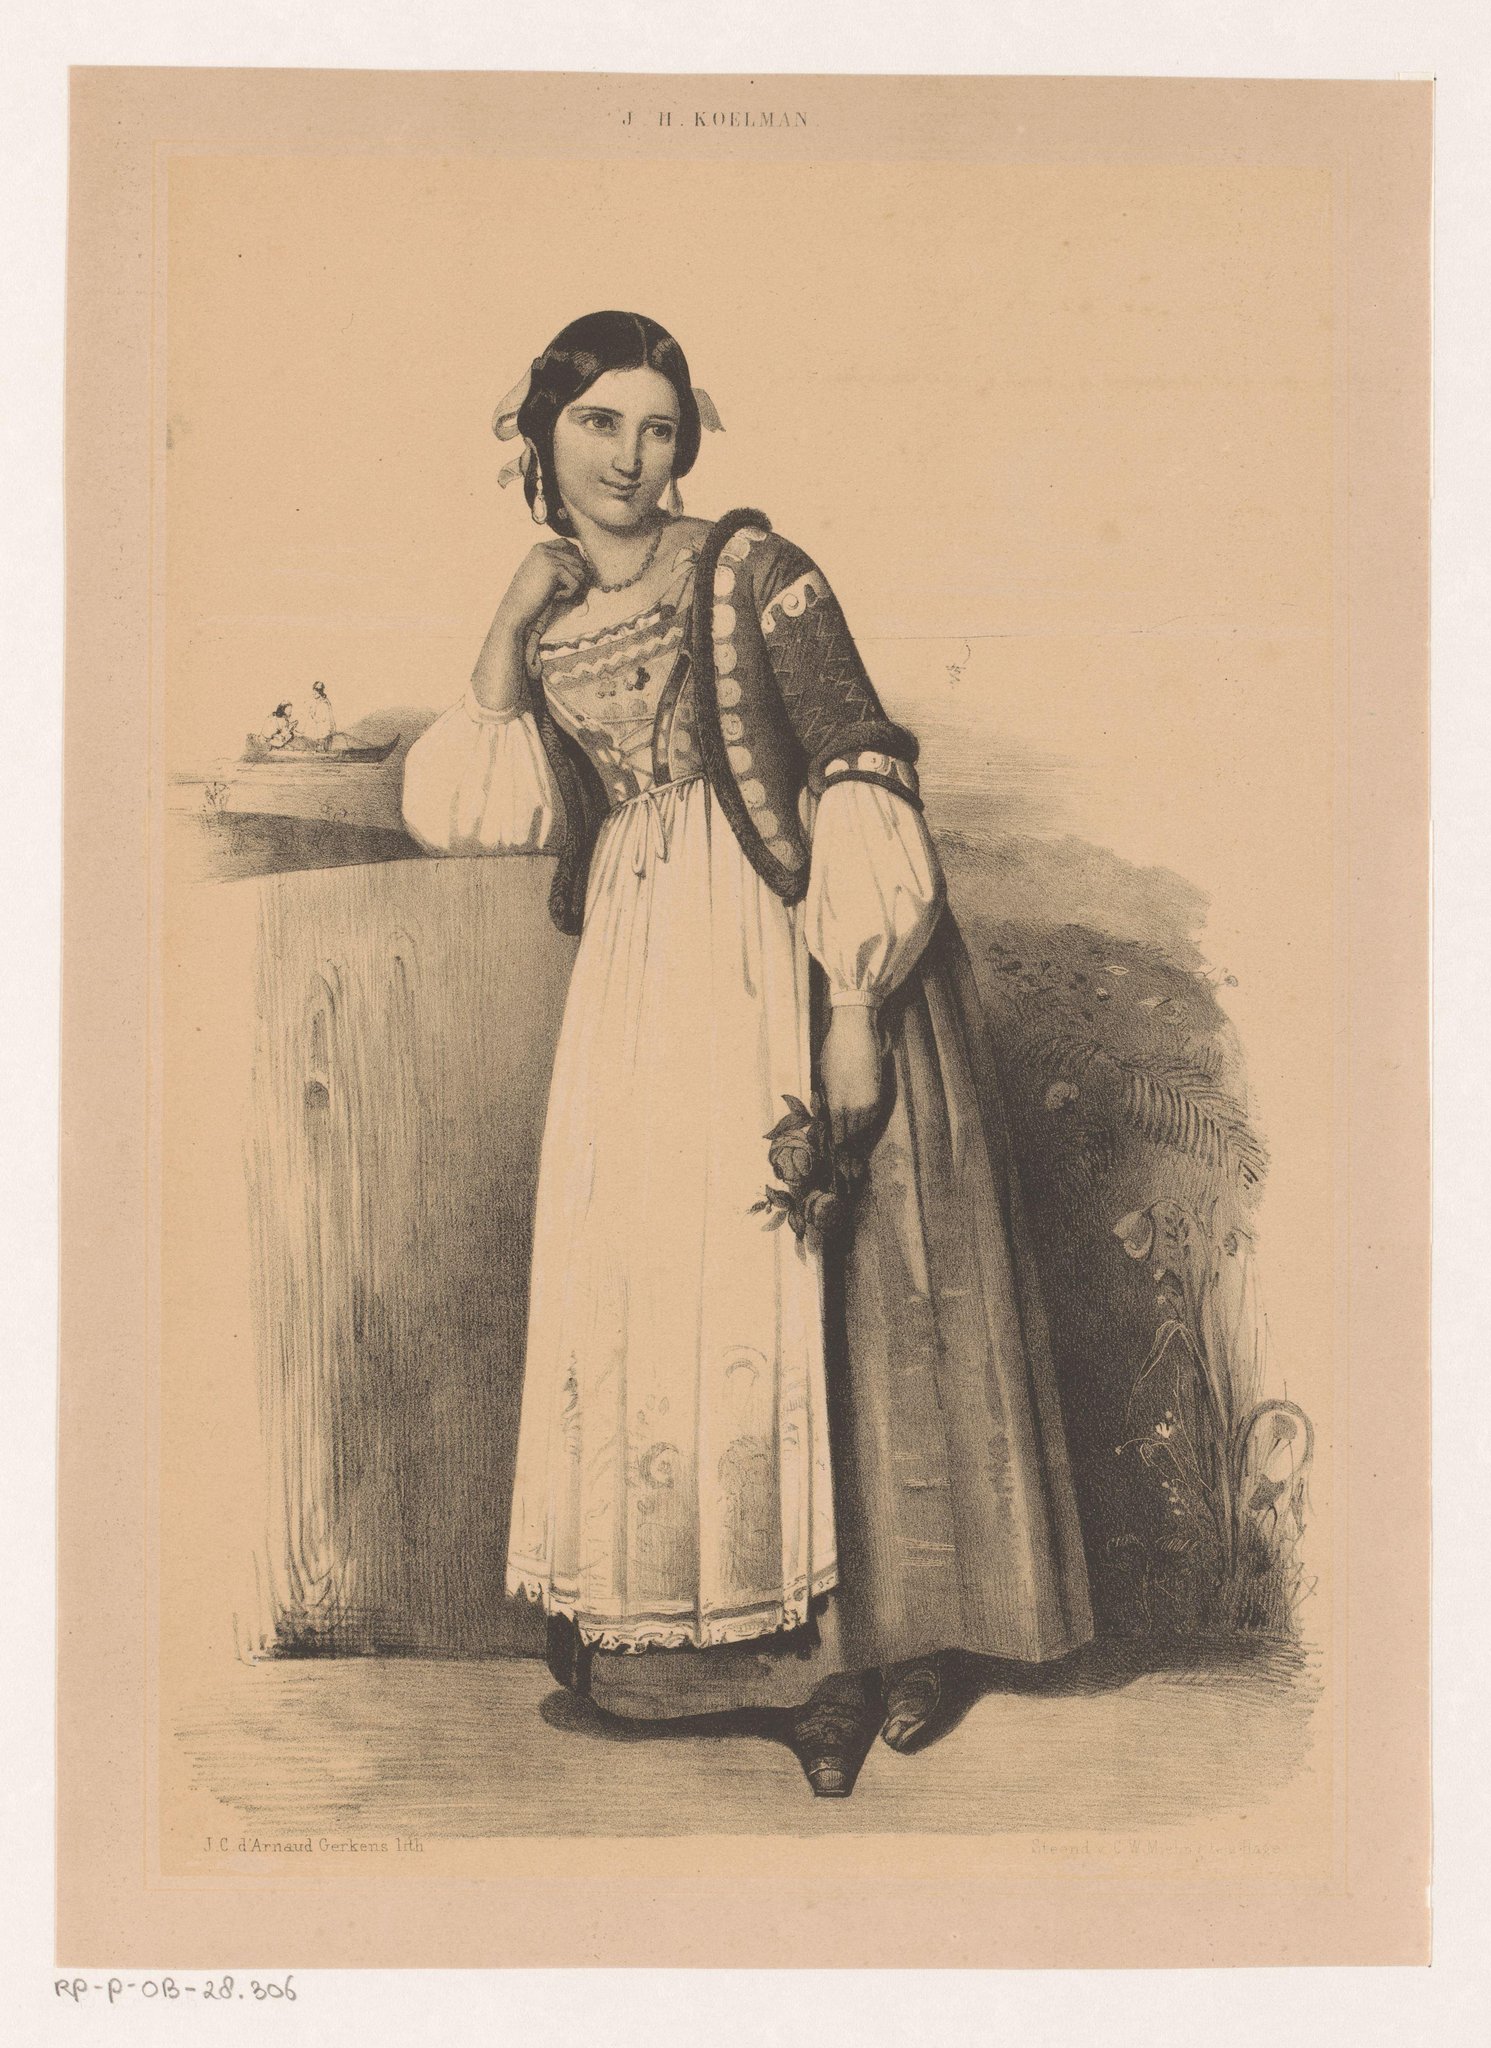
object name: print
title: Vrouw in Italiaanse klederdracht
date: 1847-1863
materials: paper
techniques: tone lithography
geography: rome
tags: adolescent, young woman, maiden, historical persons - bb - woman (+ full length portrait), rowing facing backward, pulling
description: De vrouw leunt tegen een houten muur. In haar linkerhand heeft ze twee rozen. Achter haar vaart een roeiboot met twee figuren.